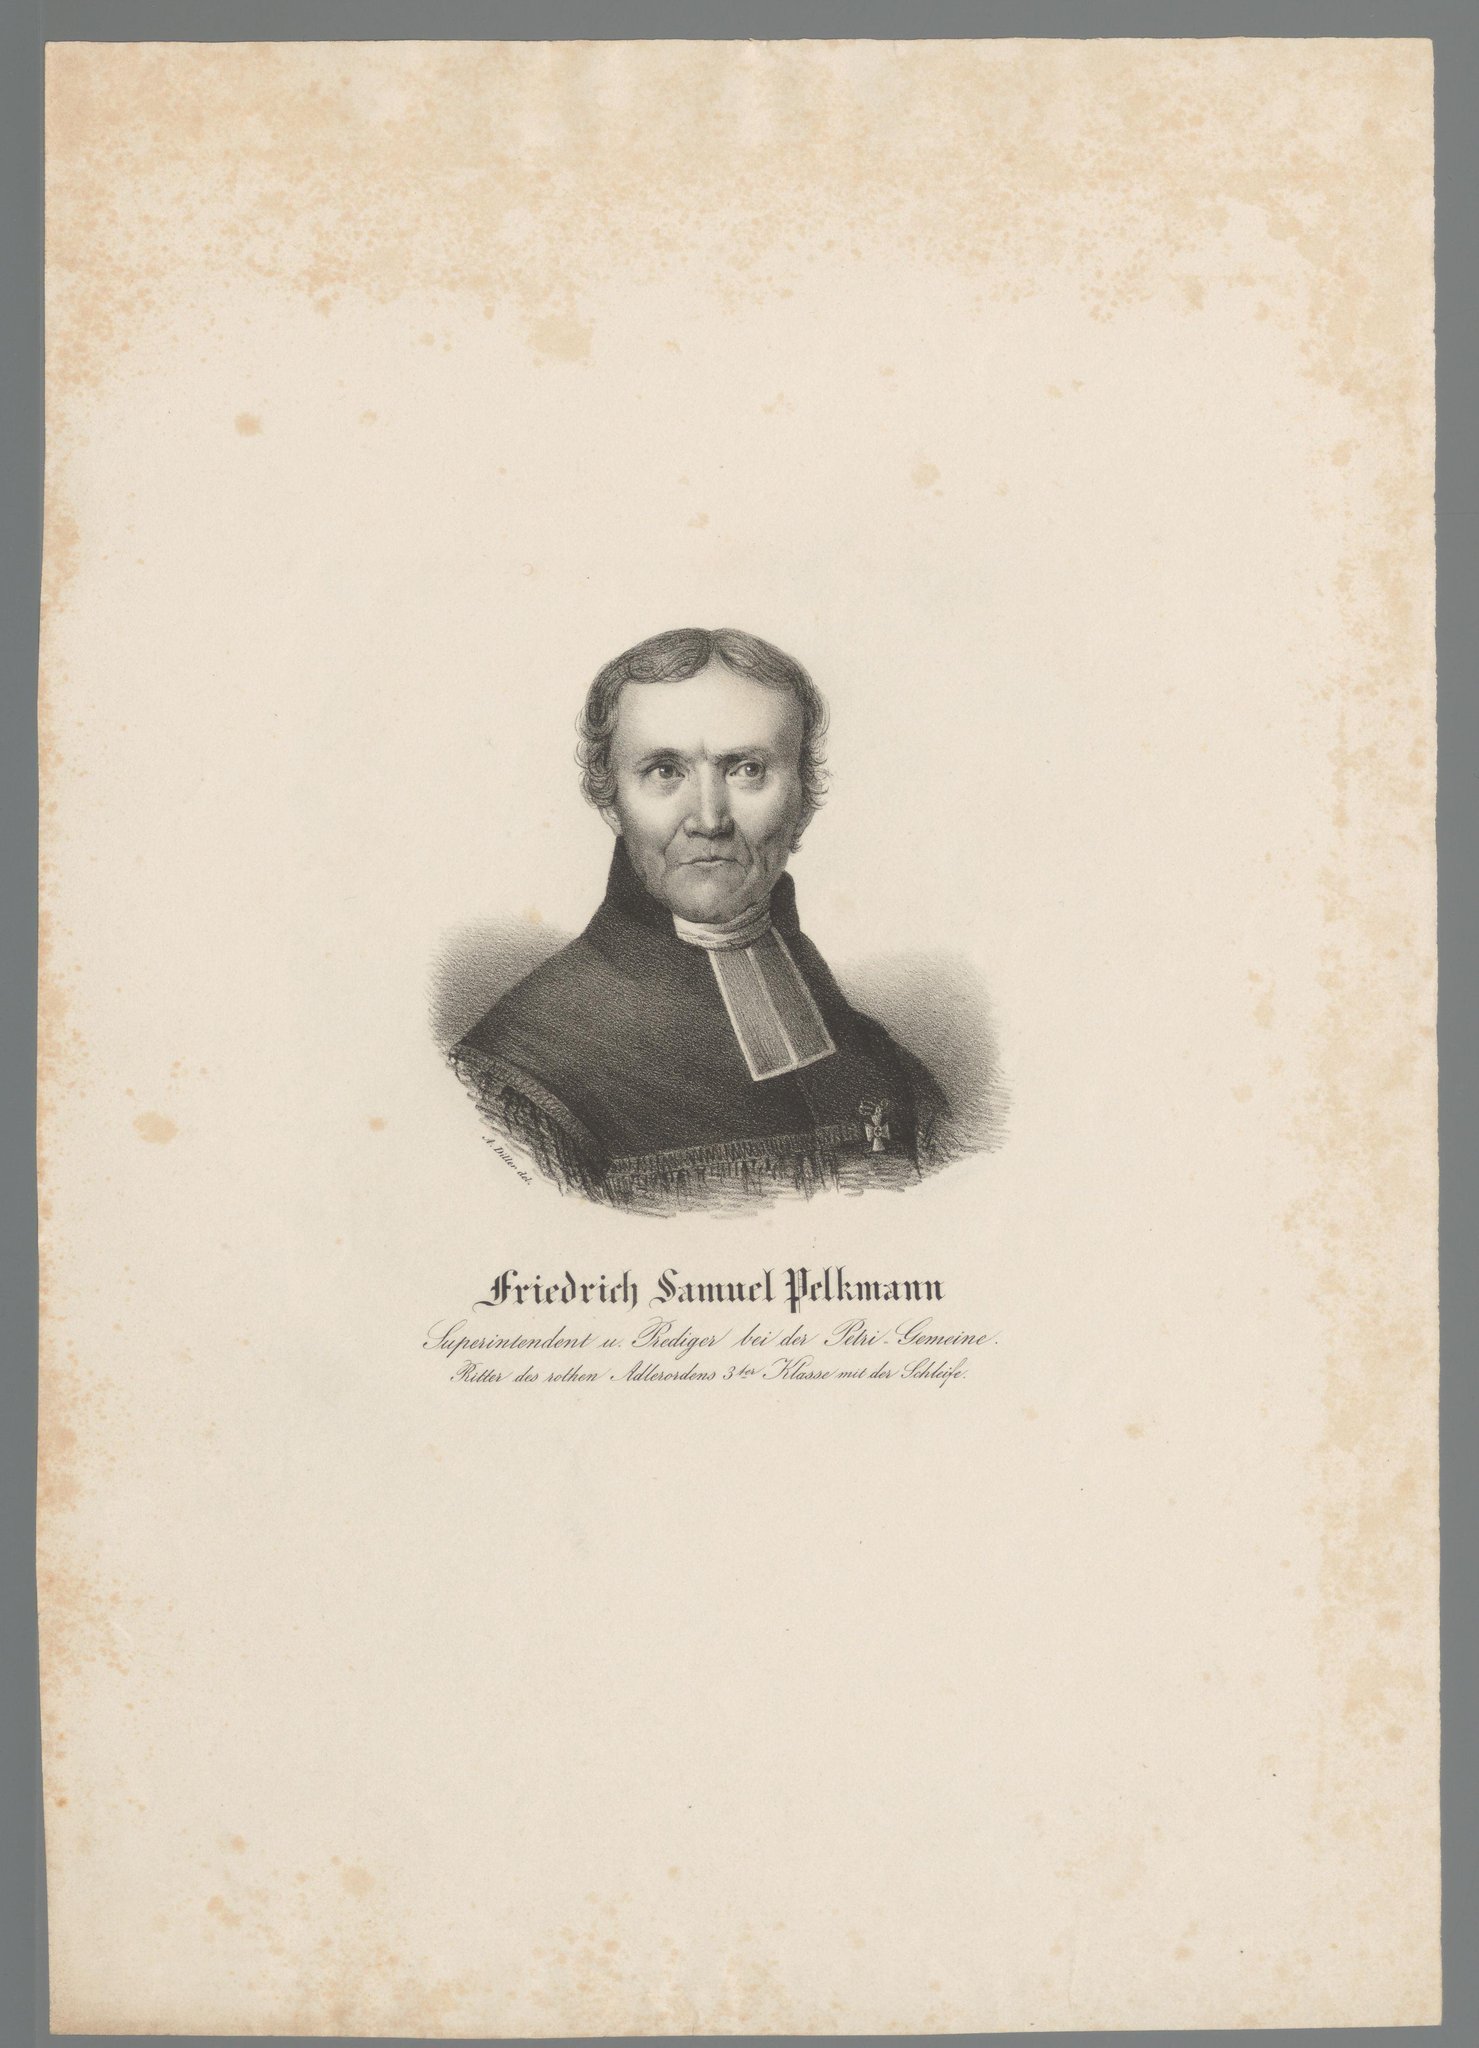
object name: print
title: Portret van Friedrich Samuel Pelkmann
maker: a. diller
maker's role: print maker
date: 1820-1850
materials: paper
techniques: lithograph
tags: clergyman, adult man, historical persons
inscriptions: collector's mark: Lugt 2228